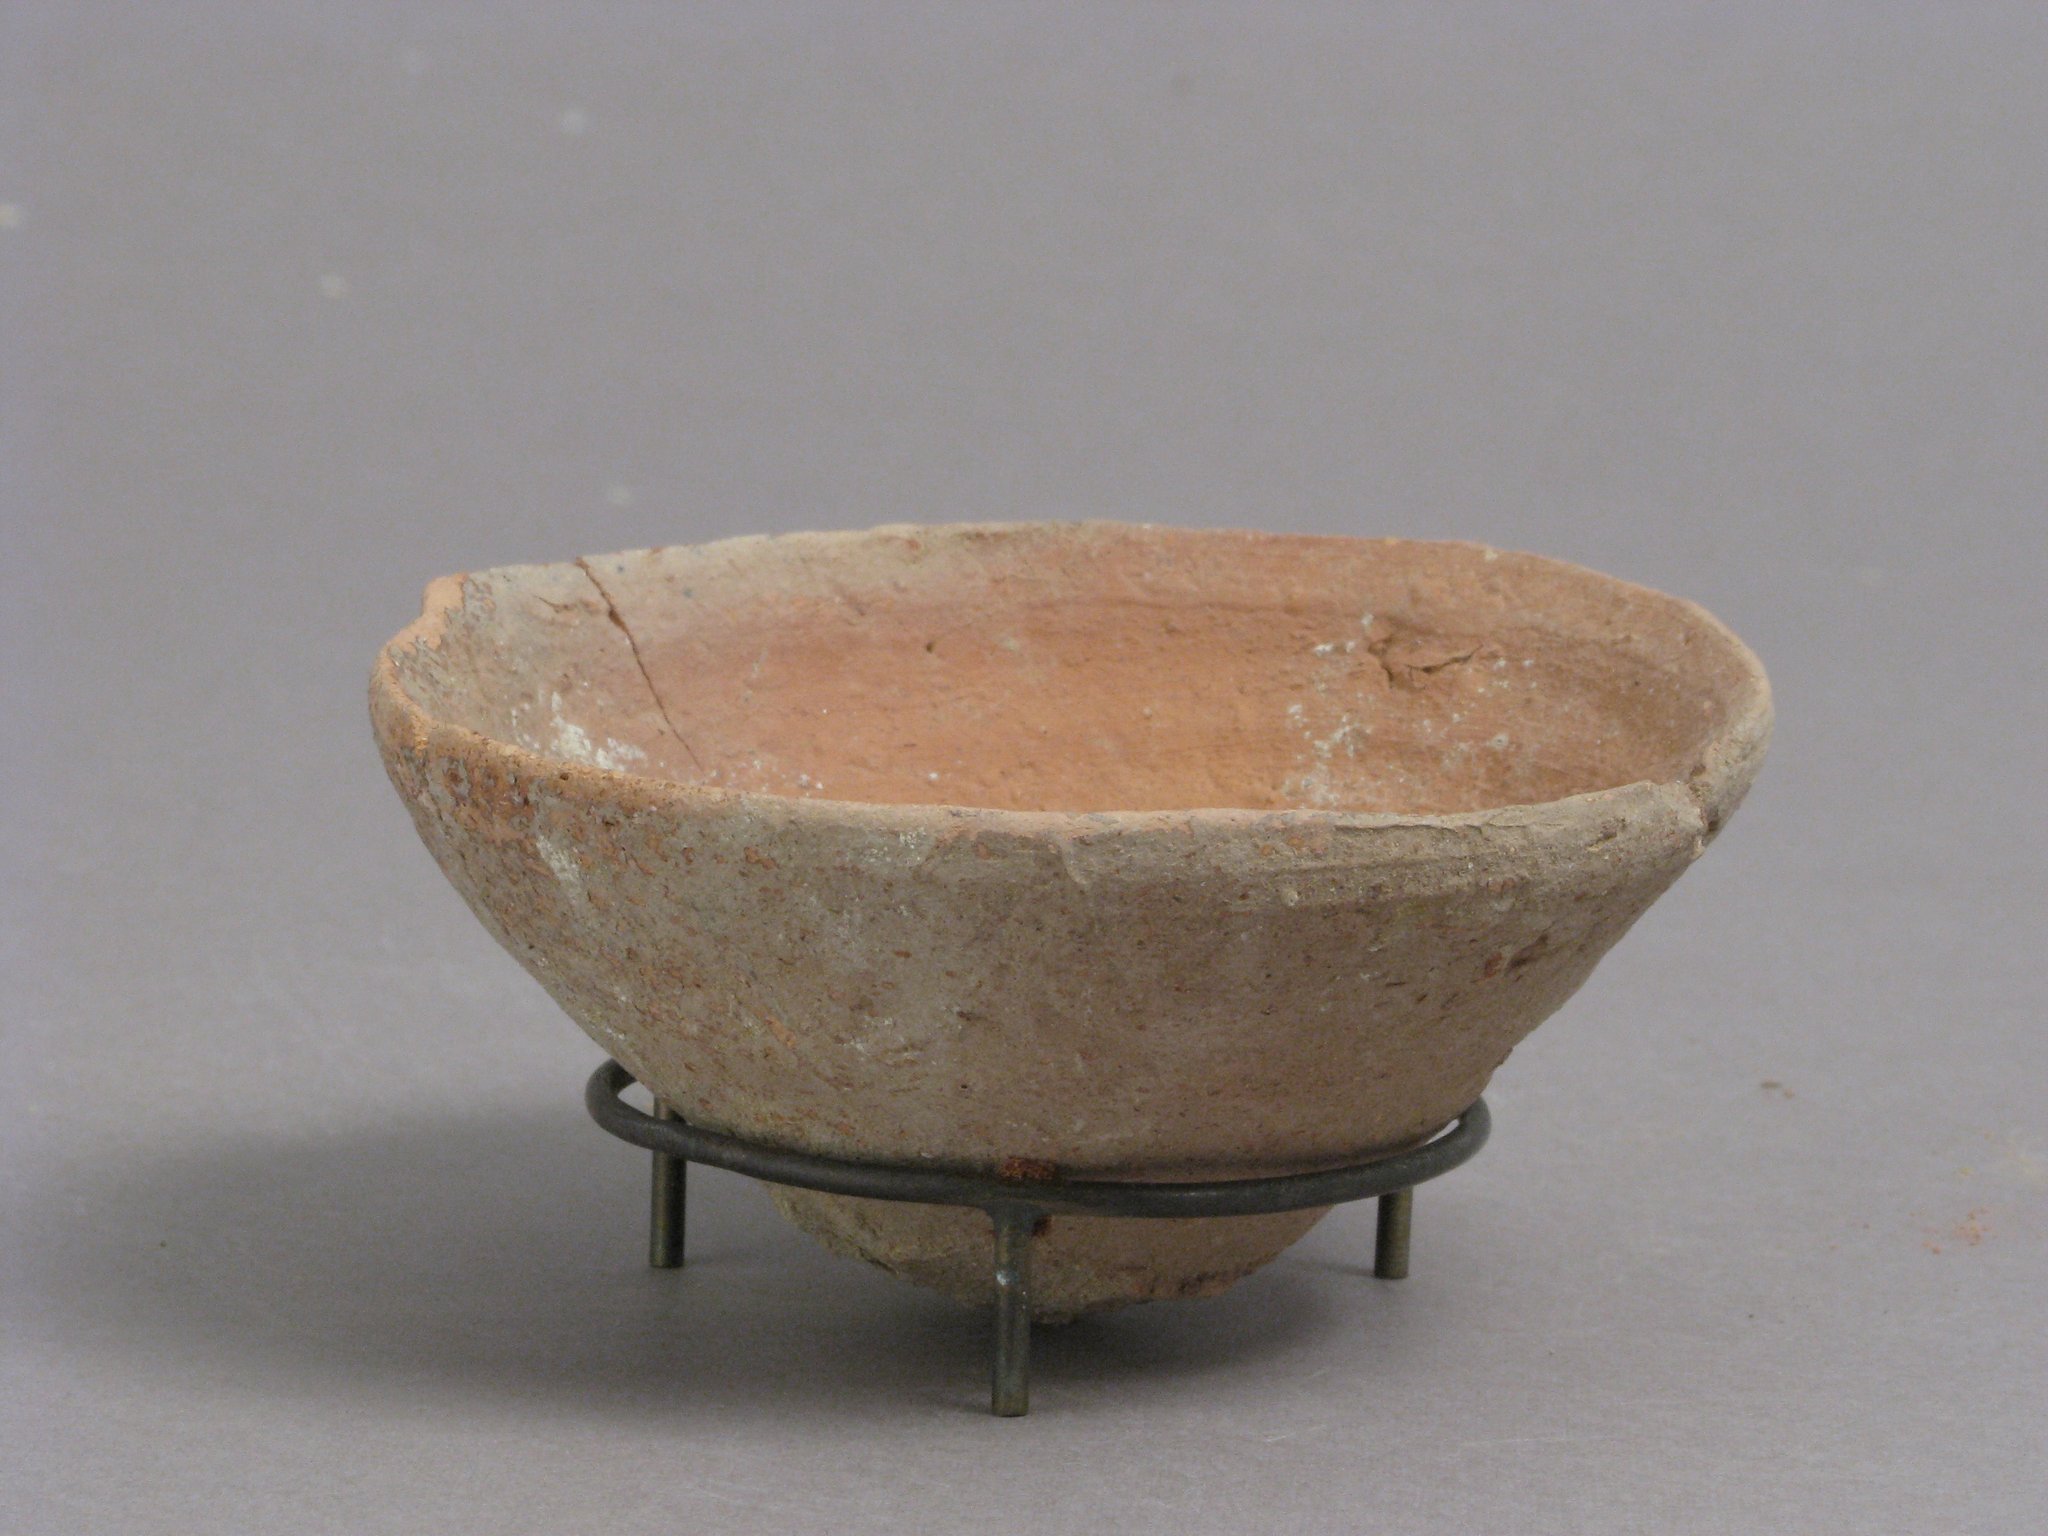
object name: cup or lid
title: Footless Cup or Lid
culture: coptic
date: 301-700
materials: earthenware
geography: egypt